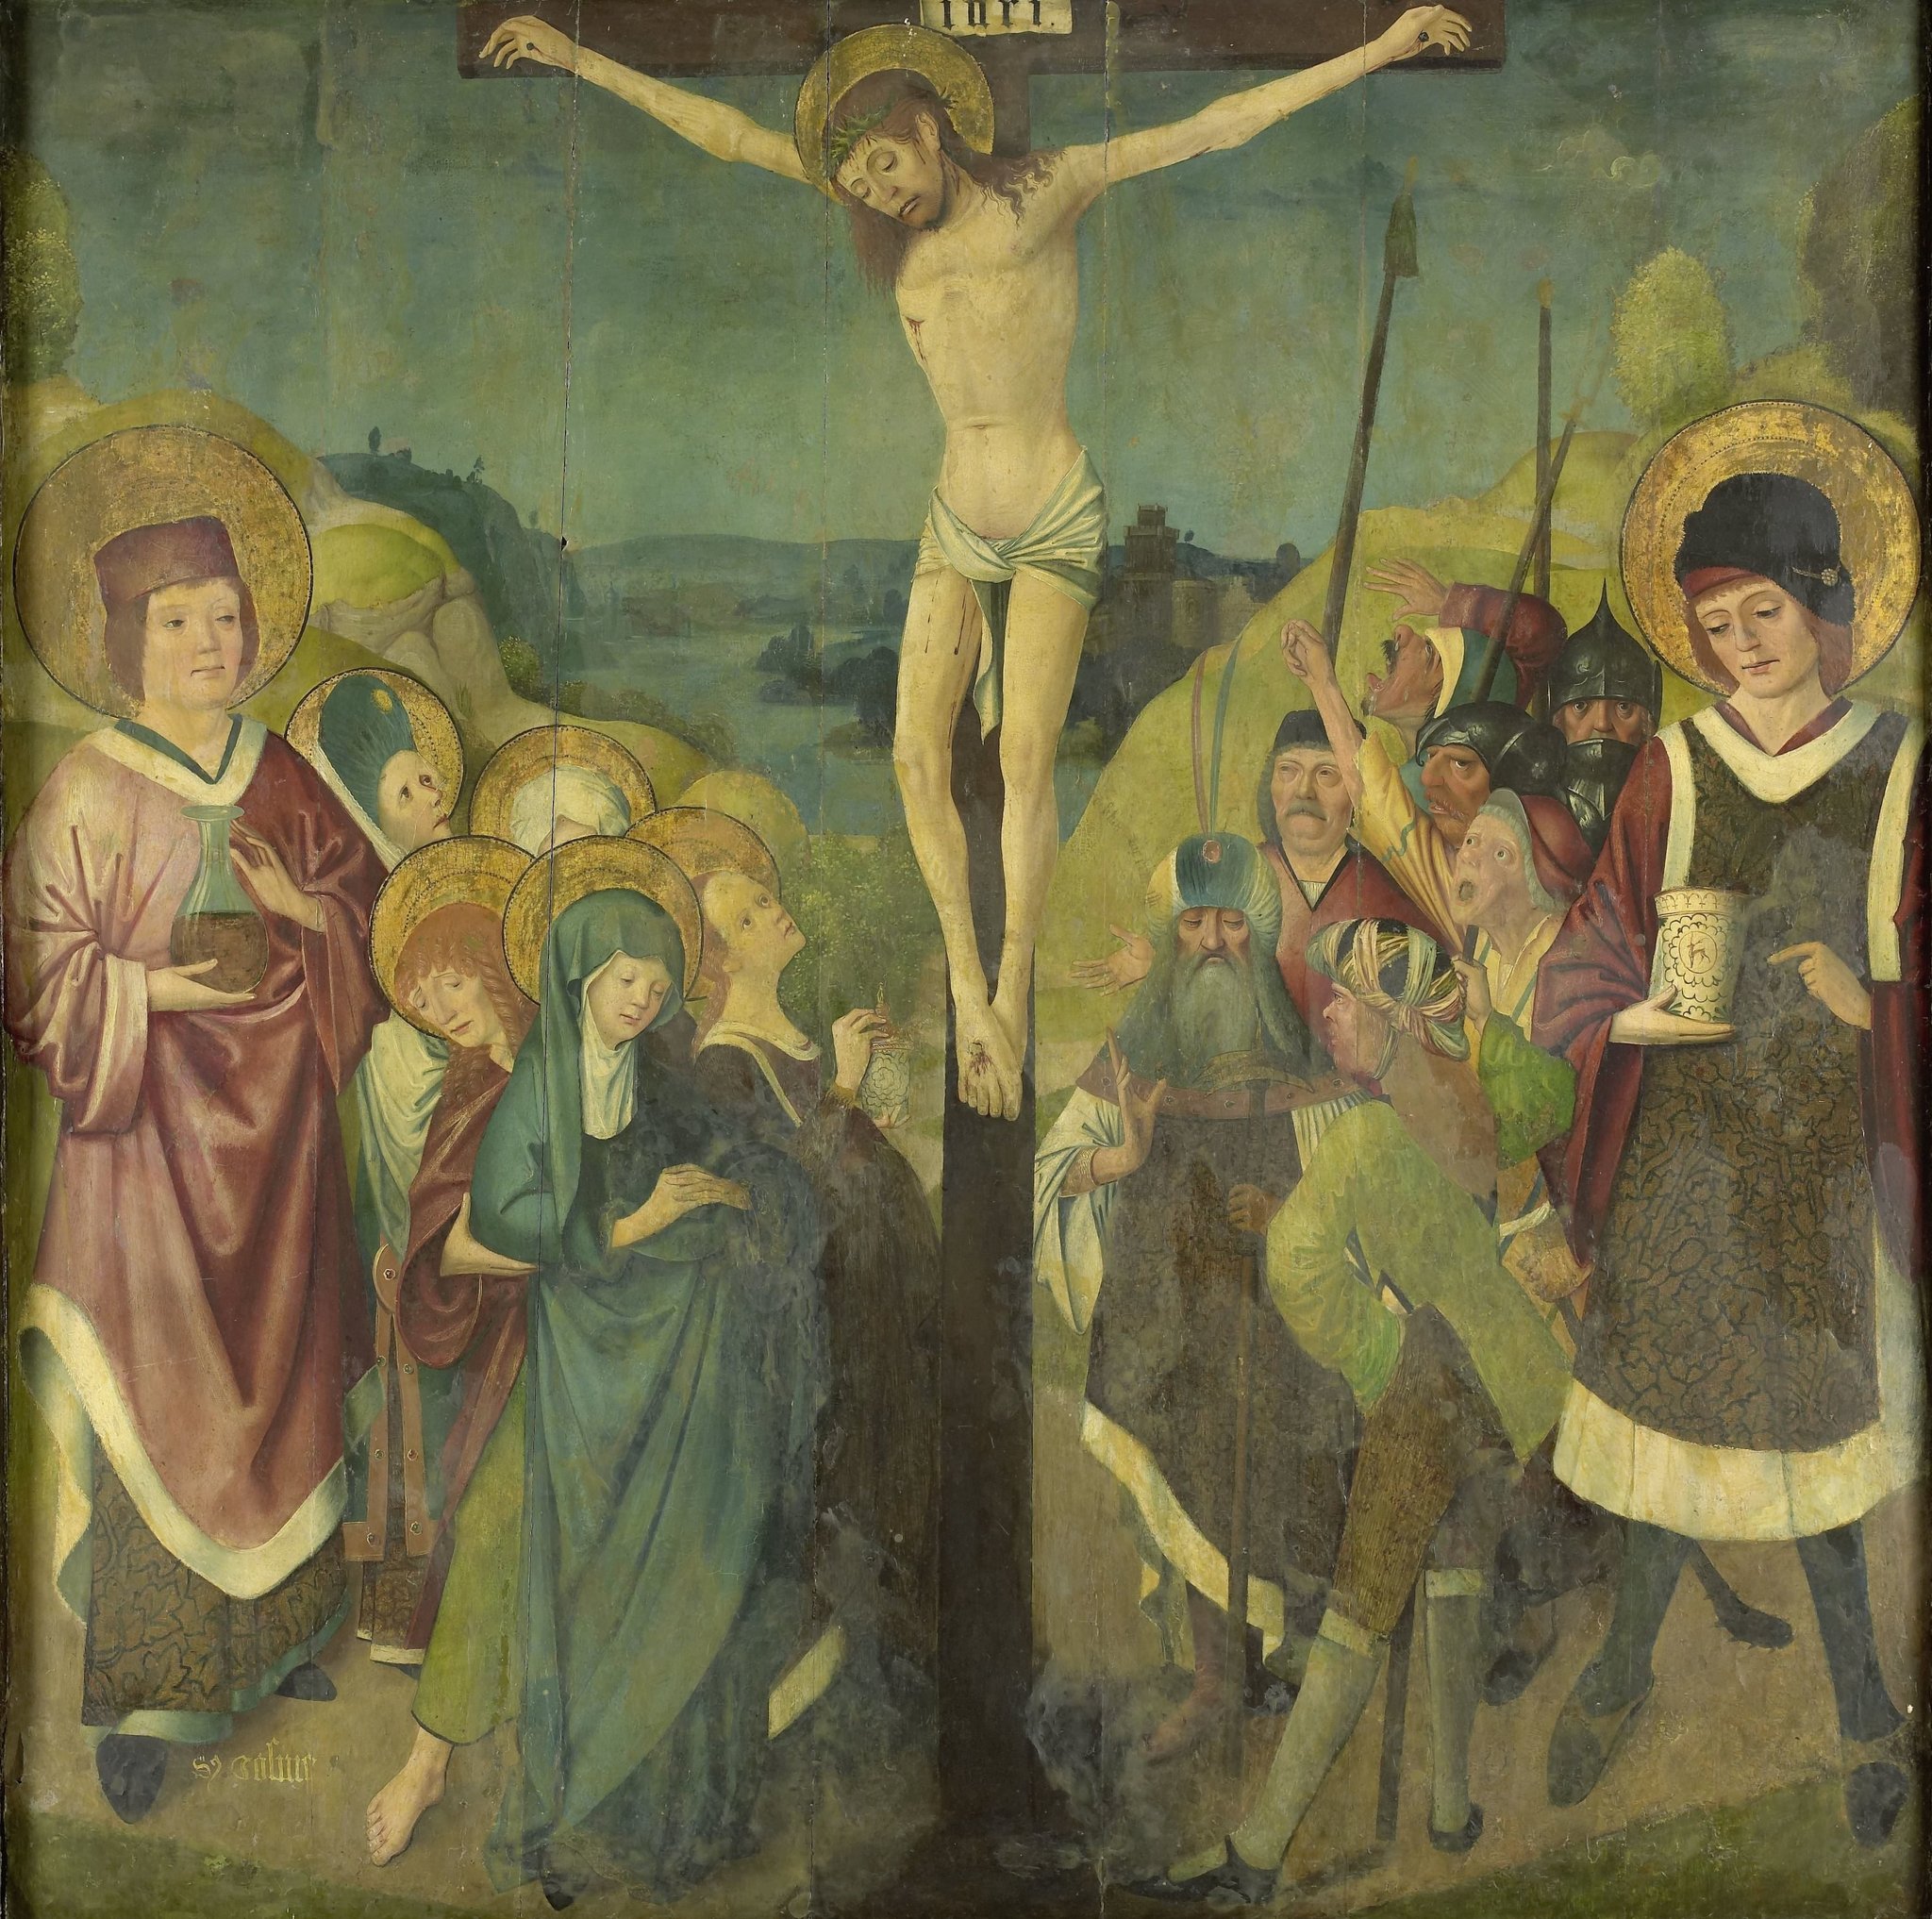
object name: painting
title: Crucifixion with Saints Cosmas and Damian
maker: Anonymous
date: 1425-1449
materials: oil, panel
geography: north germany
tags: comprehensive representations of the events on golgotha during christ's hanging on the cross, no particular event emphasized, the twin-brothers cosmas and damian(us), martyrs and physicians; possible attributes: box of ointment, cap, gown, lancet, pestle and mortar, urinal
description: Kruisiging met de heiligen Cosmas en Damianus. Christus aan het kruis, links Johannes, Maria, Maria Magdalena en de heilige Cosmas; rechts Pilatus, soldaten en de heilige Damianus.